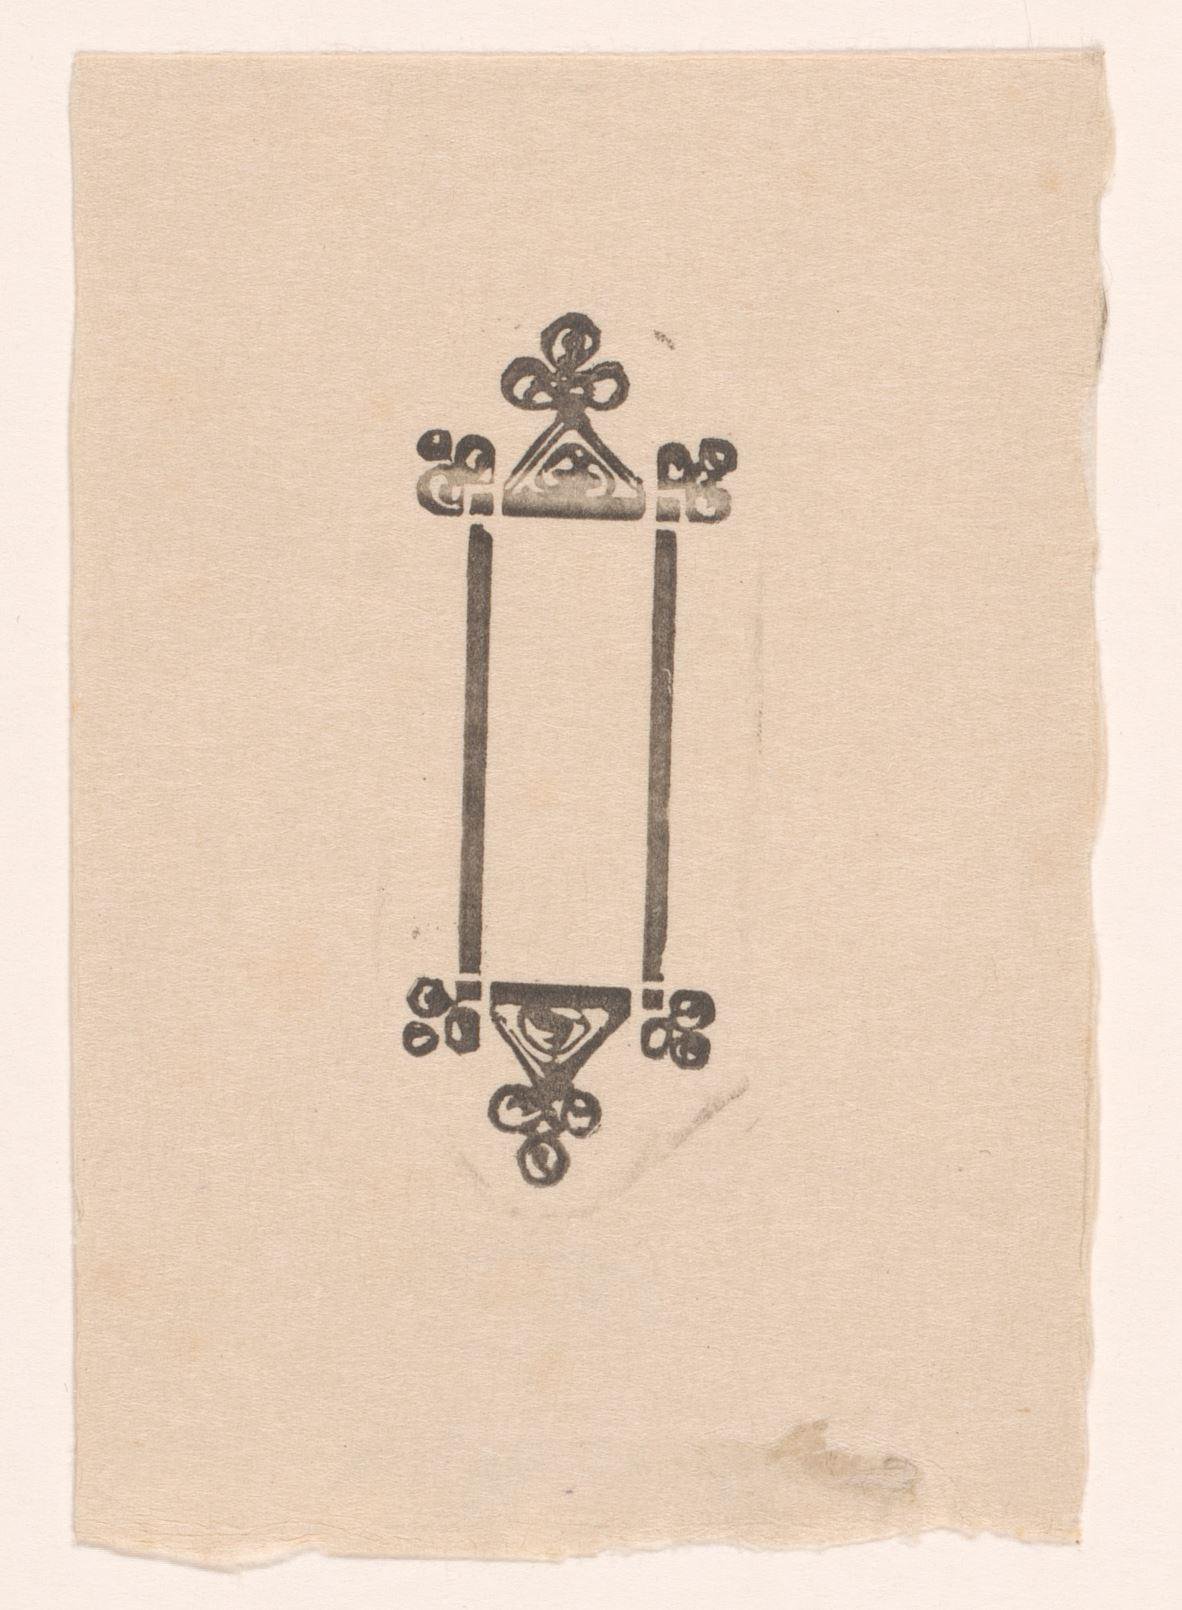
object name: print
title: Ornament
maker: bernard willem wierink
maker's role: draughtsman, print maker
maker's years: 1856-1939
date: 1910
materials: paper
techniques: relief print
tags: ornaments ~ art, fable of reynard the fox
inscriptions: collector's mark: Lugt 2228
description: Ontwerp voor: Streuvels, Stijn (Frank Lateur). Reinaert de Vos naar verschillende uitgaven van het middeleeuwsche epos. Amsterdam: L.J. Veen, 1910. Deze prent is vermoedelijk een plaatsnede, ook al wordt in de literatuur veelal gesproken over een houtsnede. Voor zover Wierink zijn prenten in hoogdruk zelf nader heeft omschreven, heeft hij altijd de term 'plaatsnede' gebruikt.